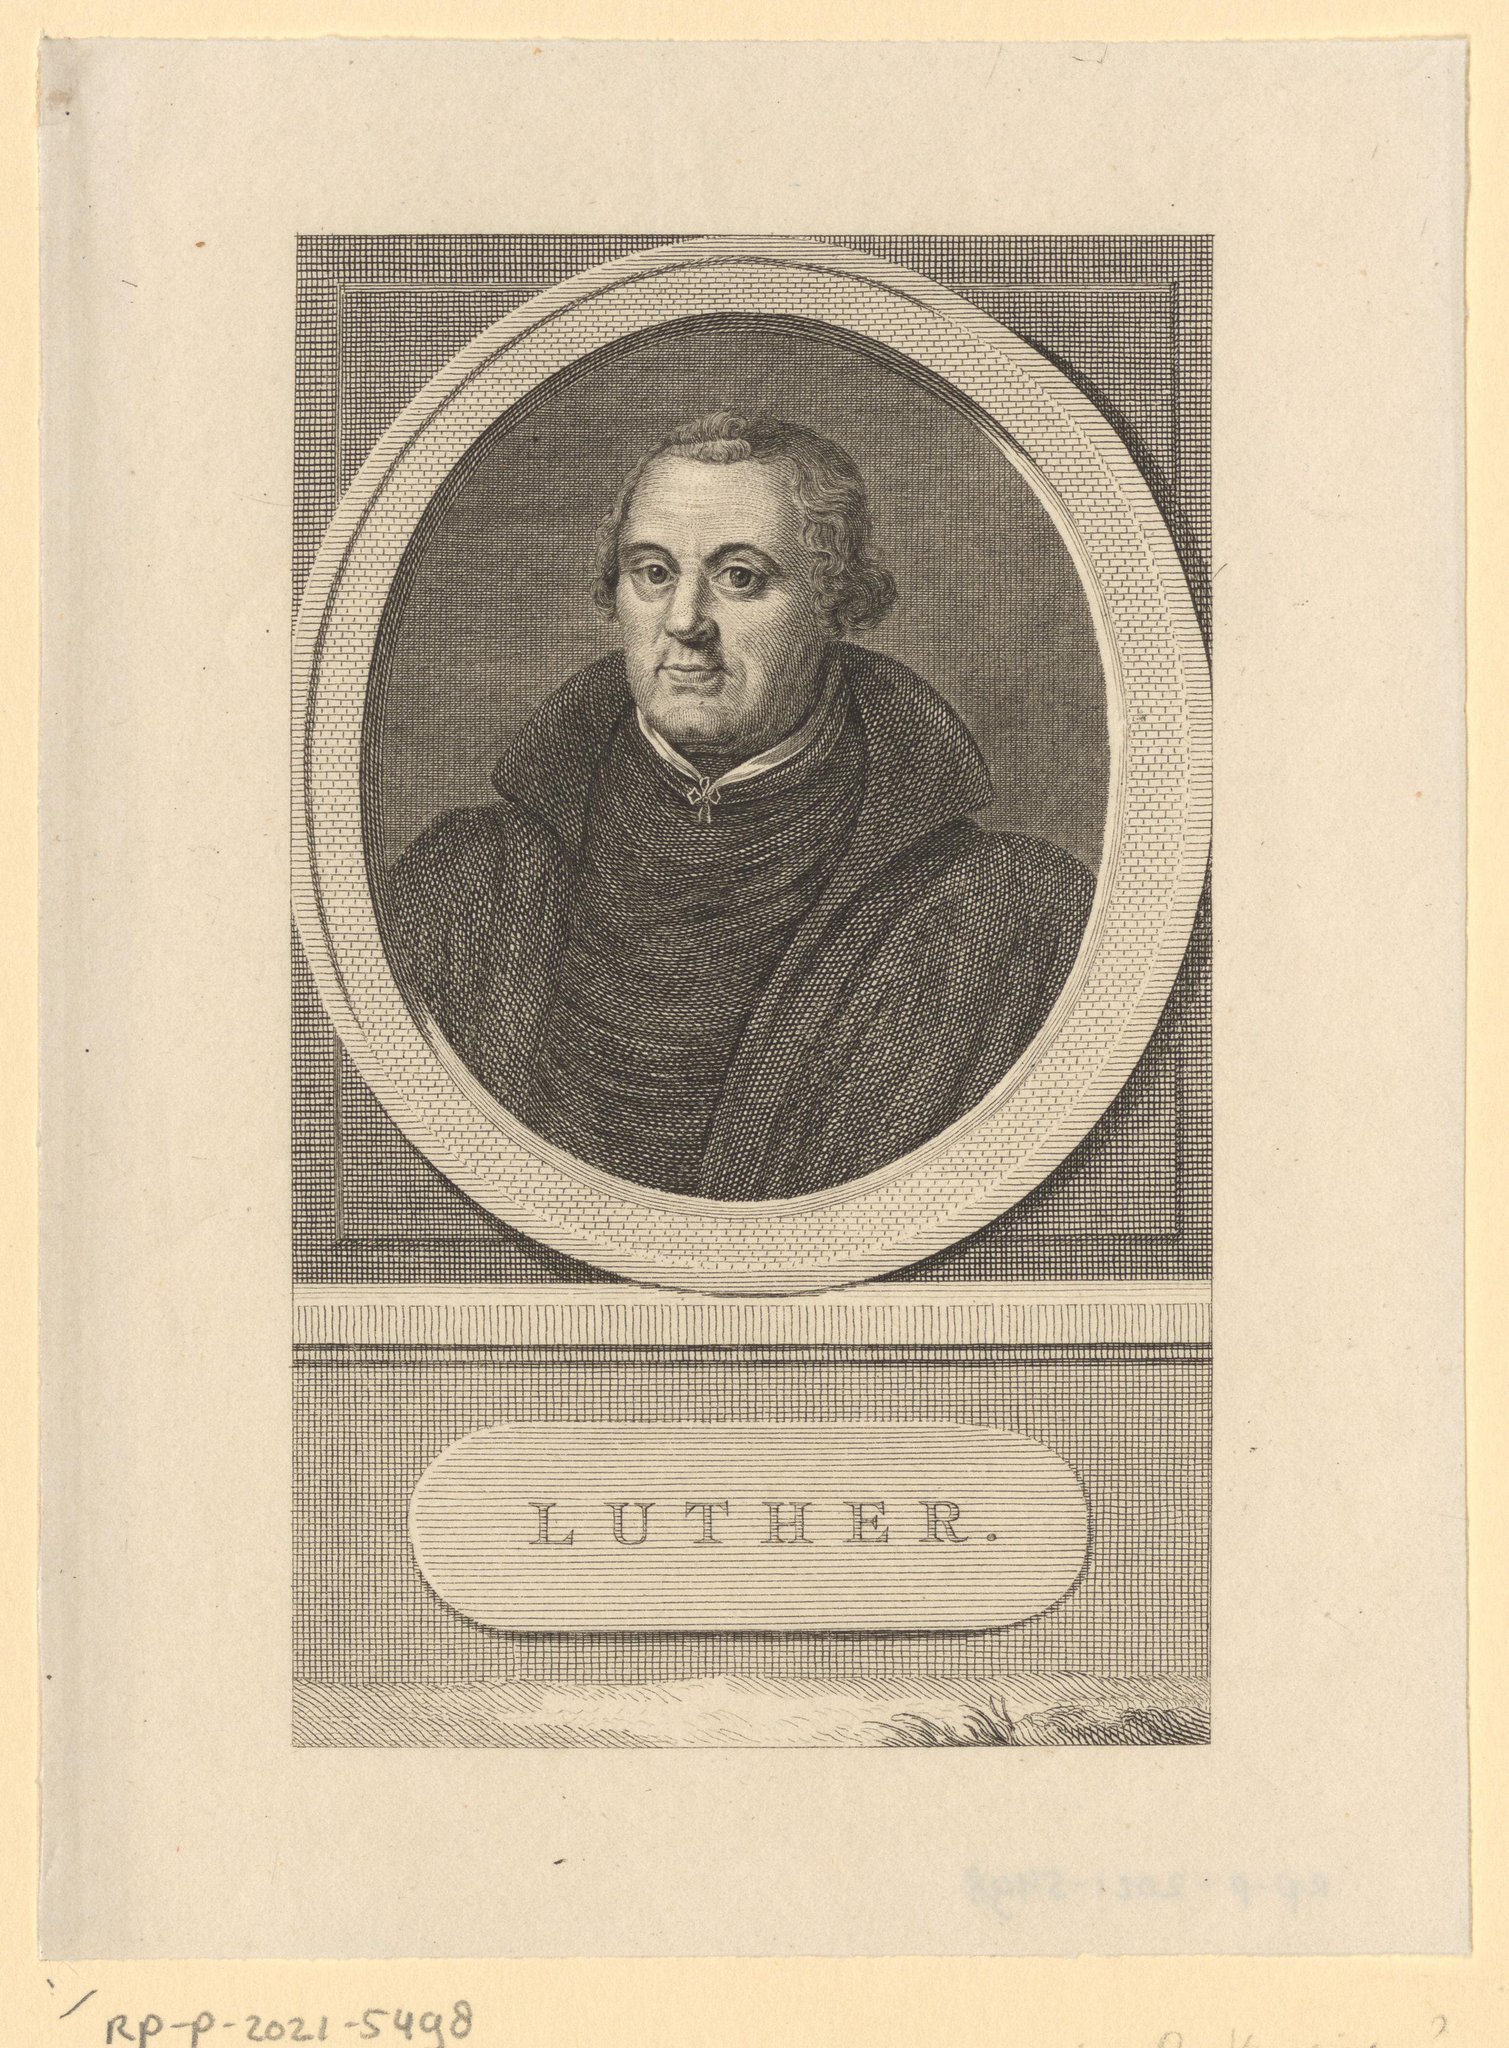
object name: print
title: Portret van Martin Luther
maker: Anonymous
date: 1750-1820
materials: paper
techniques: etching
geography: northern netherlands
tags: priest, martin luther, theologian, ornament ~ medallion, historical persons